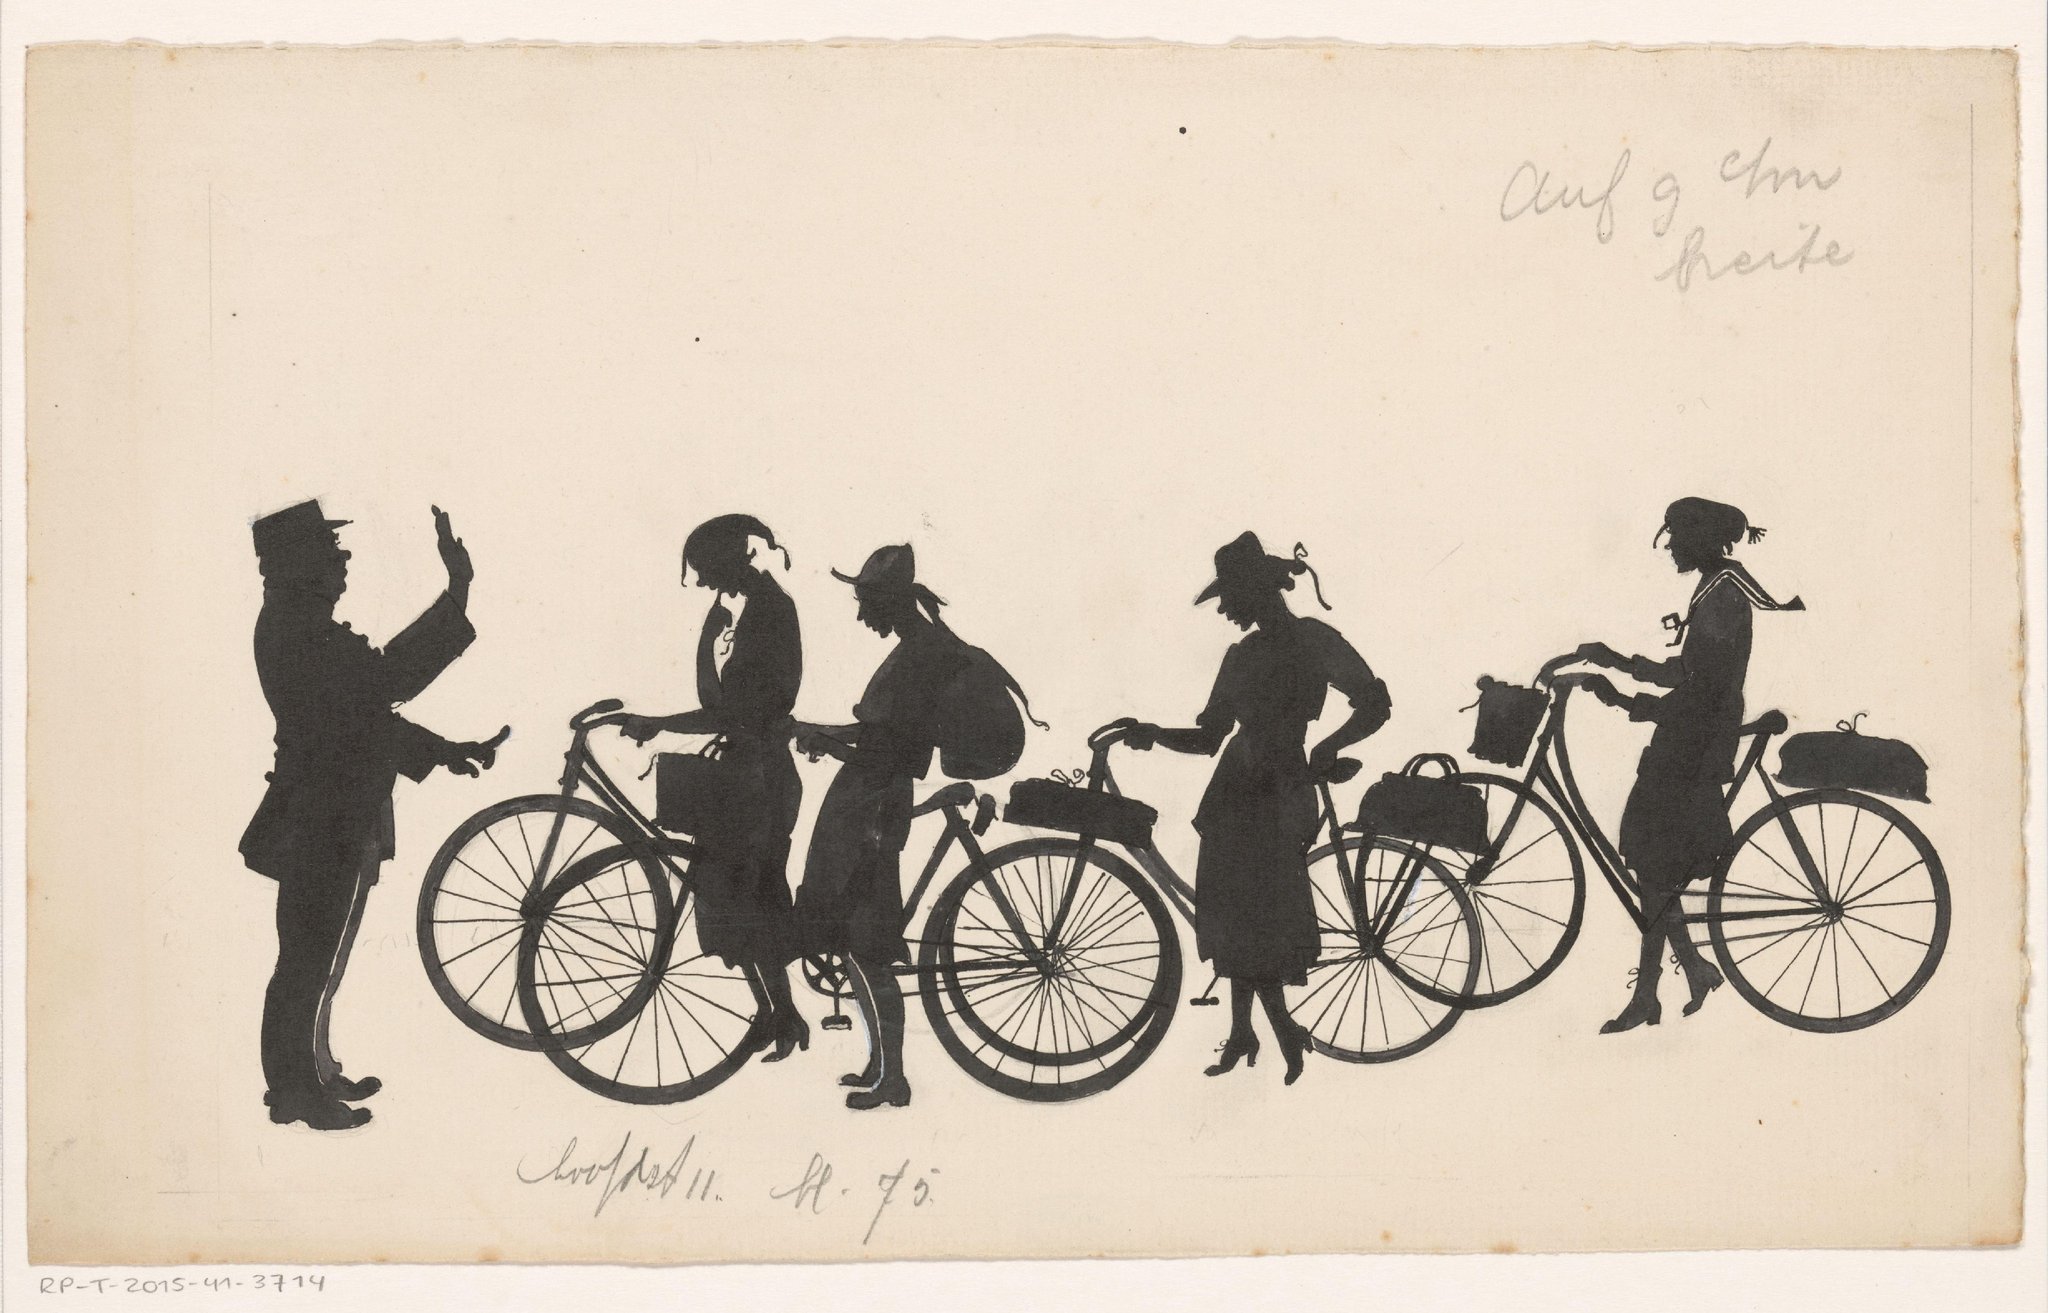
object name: boekillustratie ontwerp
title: Fietsende meisjes krijgen stopteken van een agent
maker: Anonymous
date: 1900-1930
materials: ink, paper, pencil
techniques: brush, pen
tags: policeman, constable, bicycle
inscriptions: :, annotation: ‘hoofdst 11. bl. 75’, collector's mark: Lugt 2228a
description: Een agent maakt een stopteken voor vier meisjes op de fiets. Ze hebben tassen en pakketten voor en achterop hun fiets gebonden.